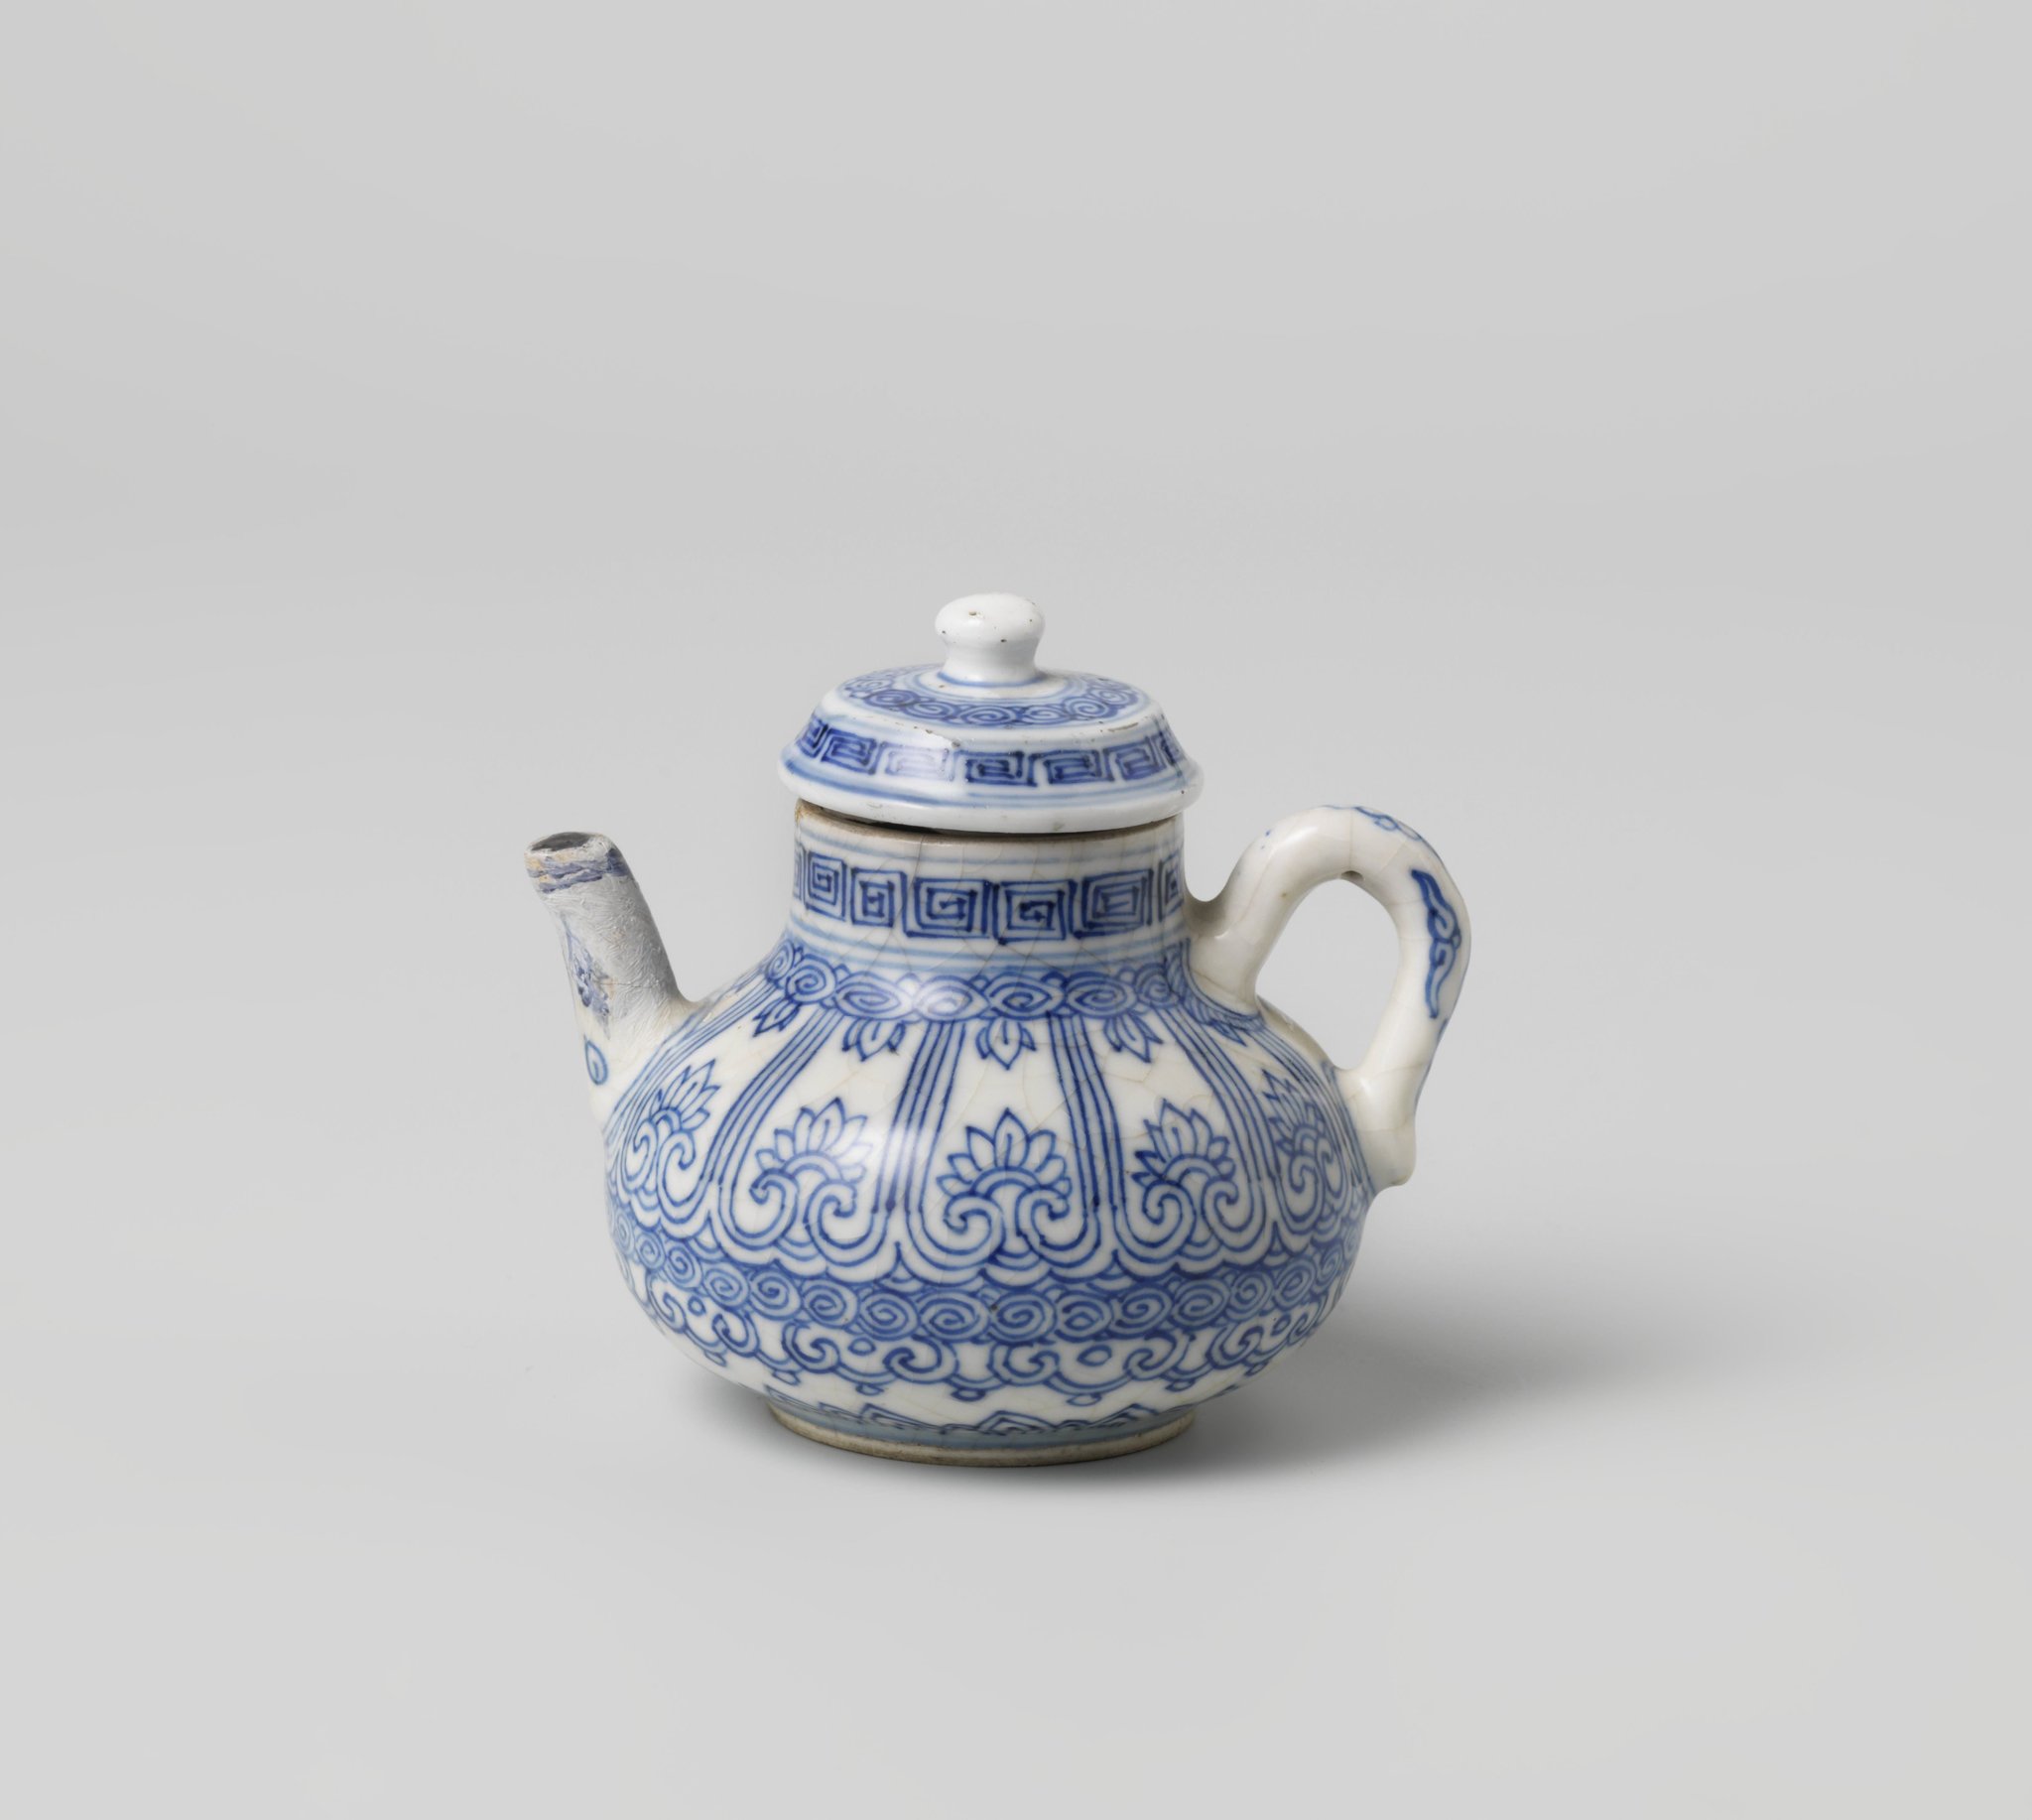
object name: teapot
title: Teapot with stylized lotus scrolls, ruyi-motif and ornamental borders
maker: Anonymous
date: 1700-1724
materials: cobalt, glaze, paint, porcelain, soft paste porcelain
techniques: firing, turning, vitrification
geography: china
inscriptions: mark: ‘玉’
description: AK-NM-6833 Twee theepotten • Blauw-wit Kangxi-porselein • Onderdeel van Royers porseleincollectie Deze theepotjes zijn gemaakt van soft paste porselein. Voor enkele opmerkingen hierover zie de toelichting bij AK-NM-6722. De soft paste ondergrond maakt gedetailleerde beschildering mogelijk. Dat is hier ook vrij meesterlijk gelukt. Het decor ontleent zijn kracht aan de regelmatigheid en de strakheid van het schilderwerk – het geheel ontbreken van elke aarzeling bij het zetten van de lijnen. Het lijkt allemaal doodsimpel, maar het verdient de aandacht. In de lading van de Vung Tau, een jonk die ca. 1690 verging, bevonden zich vergelijkbare, maar minder zorgvuldig beschilderde voorbeelden [Vung Tau 1992, nr. 213]. Verder is het interessant vast te stellen dat zowel Herman Karel Westendorp (1868-1941) (AK-MAK-562) als Sir Percival David (1892-1964) [Medley 1976, nr. 658, p. 25, pl. II] zo’n potje in de collectie hadden, beiden verzamelaars van ‘Chinese taste’ porselein, porselein dat voor een Chinese kritische clientèle werd gemaakt. Maar de aanwezigheid in de Vung Tau lading en in de collectie van Royer toont aan dat deze potjes al in de Kangxi-tijd naar Europa verscheept werden. Bronnen: Margaret Medley, Illustrated catalogue of underglaze blue and copper red decorated porcelains, Londen, 1976. The Vung Tau cargo: Chinese export porcelain. Veilingcatalogus Christie’s Amsterdam, 7 April 1992.